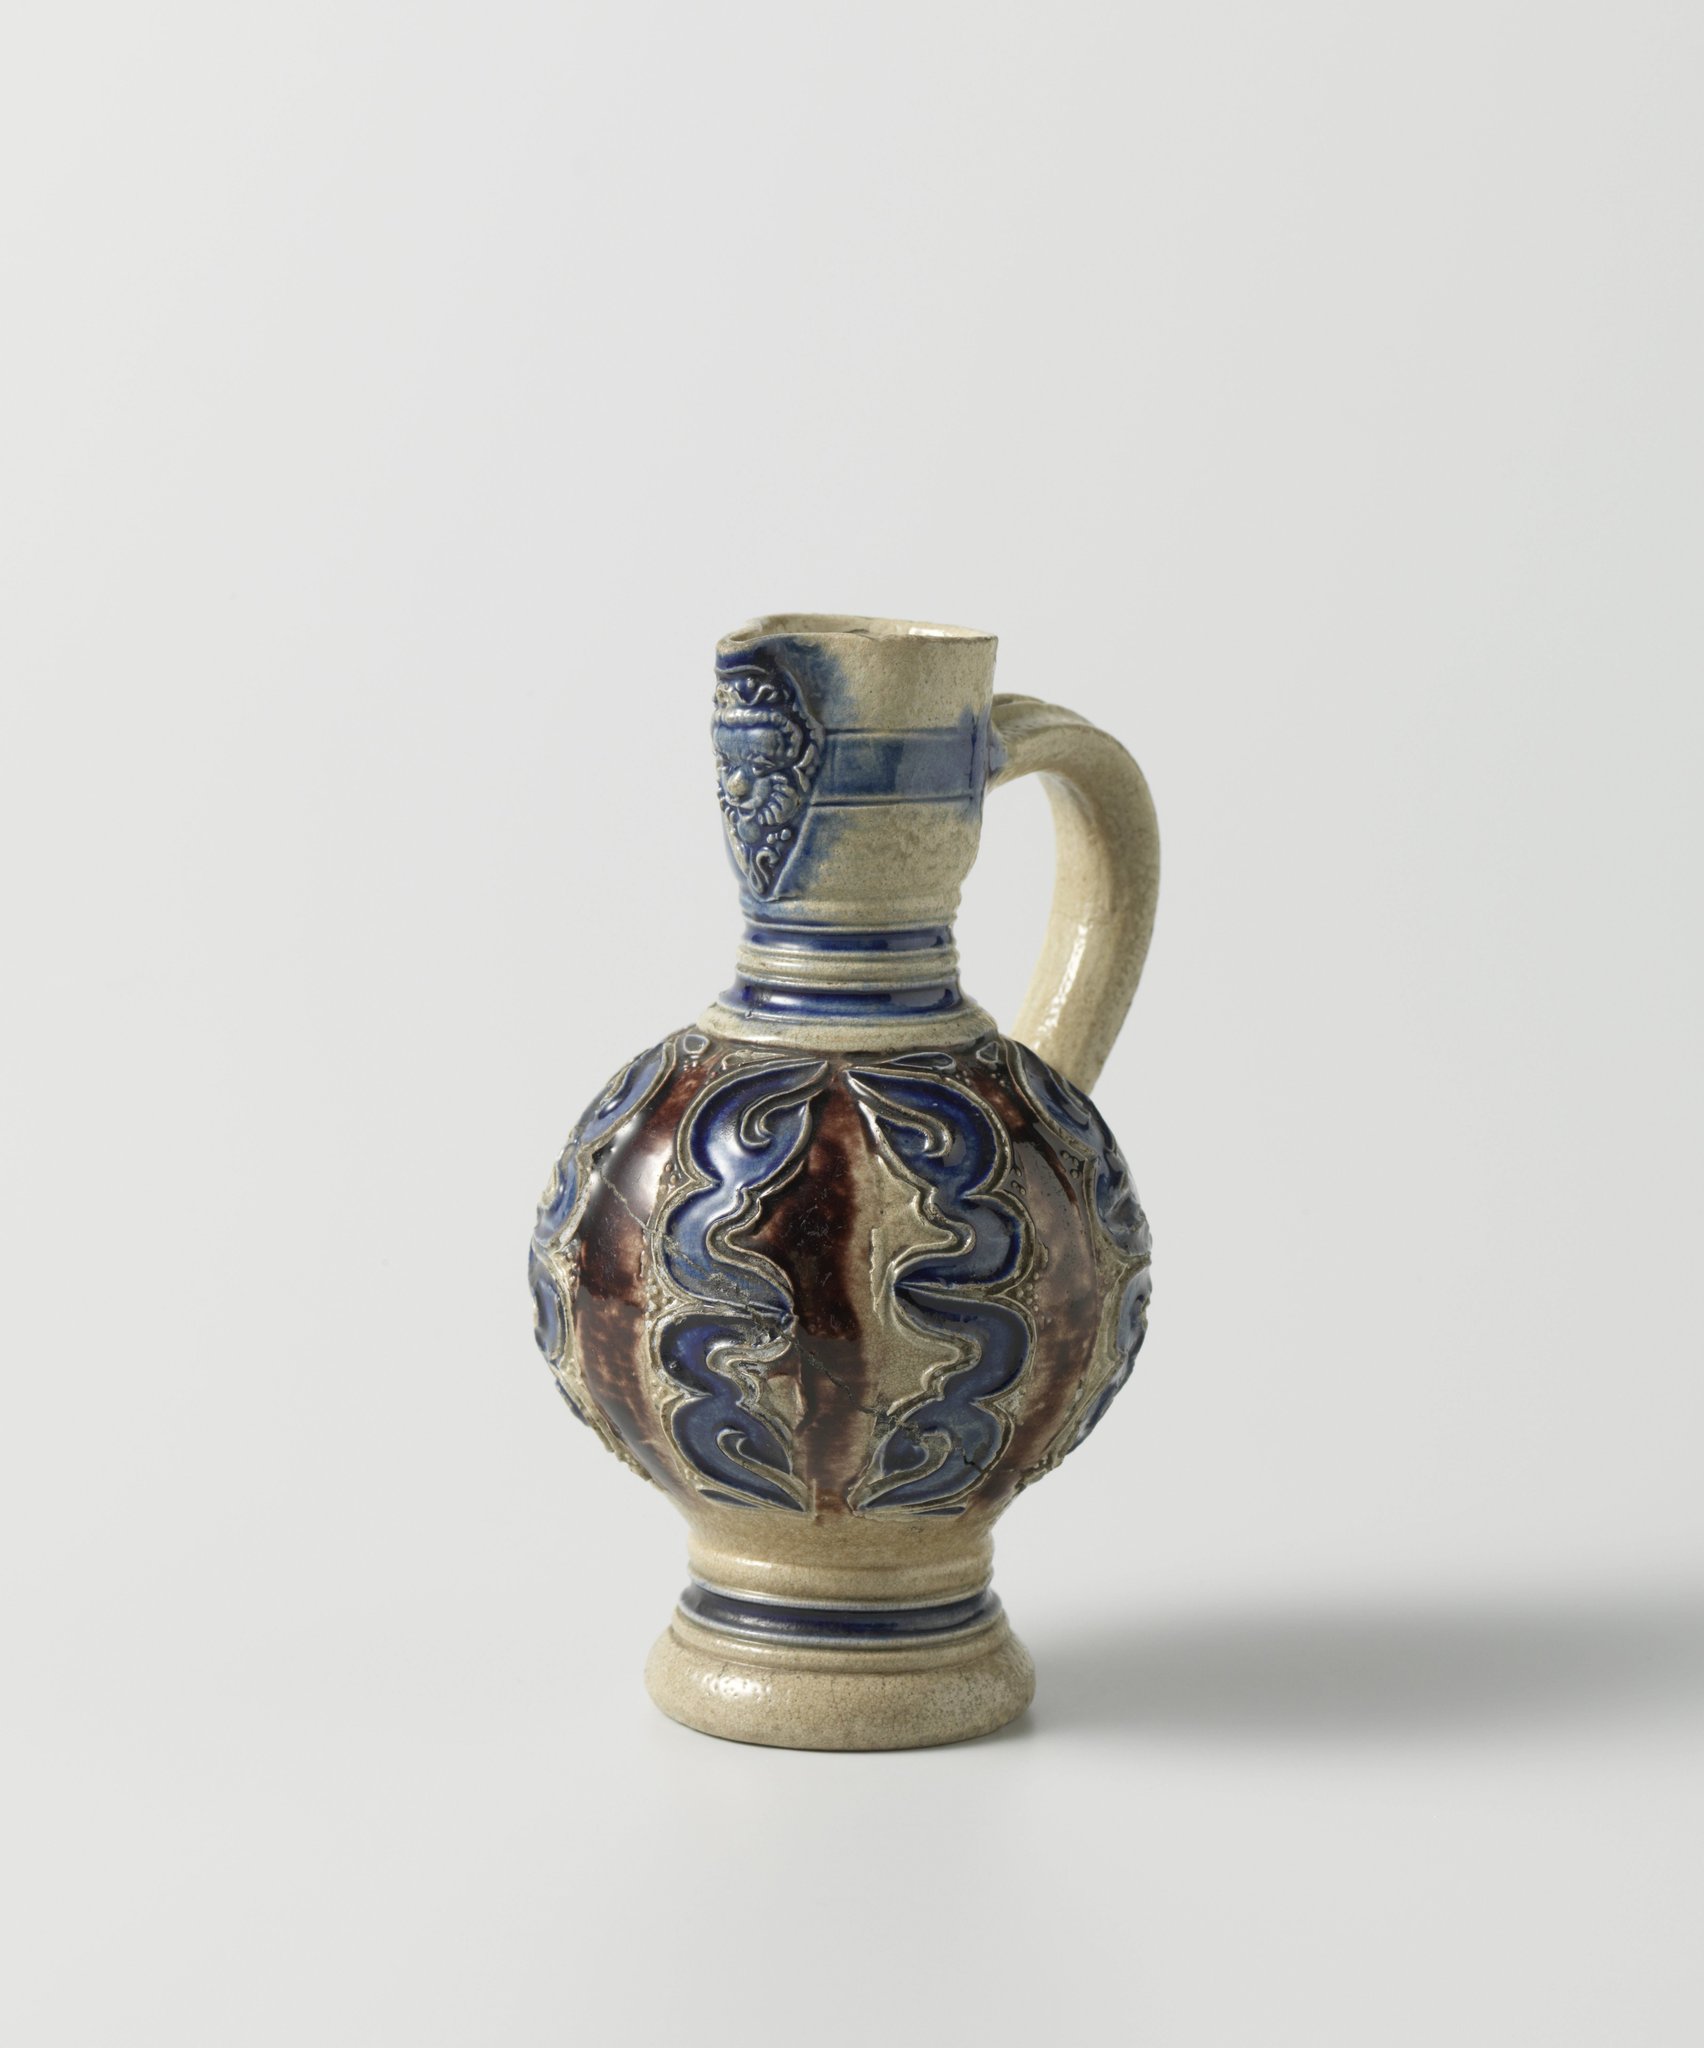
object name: ewer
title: Jug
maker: Anonymous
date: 1650-1699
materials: cobalt, glaze, mineral, stoneware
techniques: firing, forming, relief, turning, vitrification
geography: westerwald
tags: mask, mascaron ~ ornament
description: Kan van steengoed op hoge voet met een bolvormig lichaan en smalle nek met een geknepen tuit. Het C-vormige oor is bevestigd aan de nek en de schouder. Profielen op de nek en de voet. Gedeeltelijk bedekt met kobaltblauw en mangaanpaars. Op de buik in reliëf verticale gedrukte en opgelegde banden met golvende lijnen in blauw; daartussen paars. Op de nek, onder de tuit, een masker. Blauwe lijnen op de nek en voet. Westerwald.